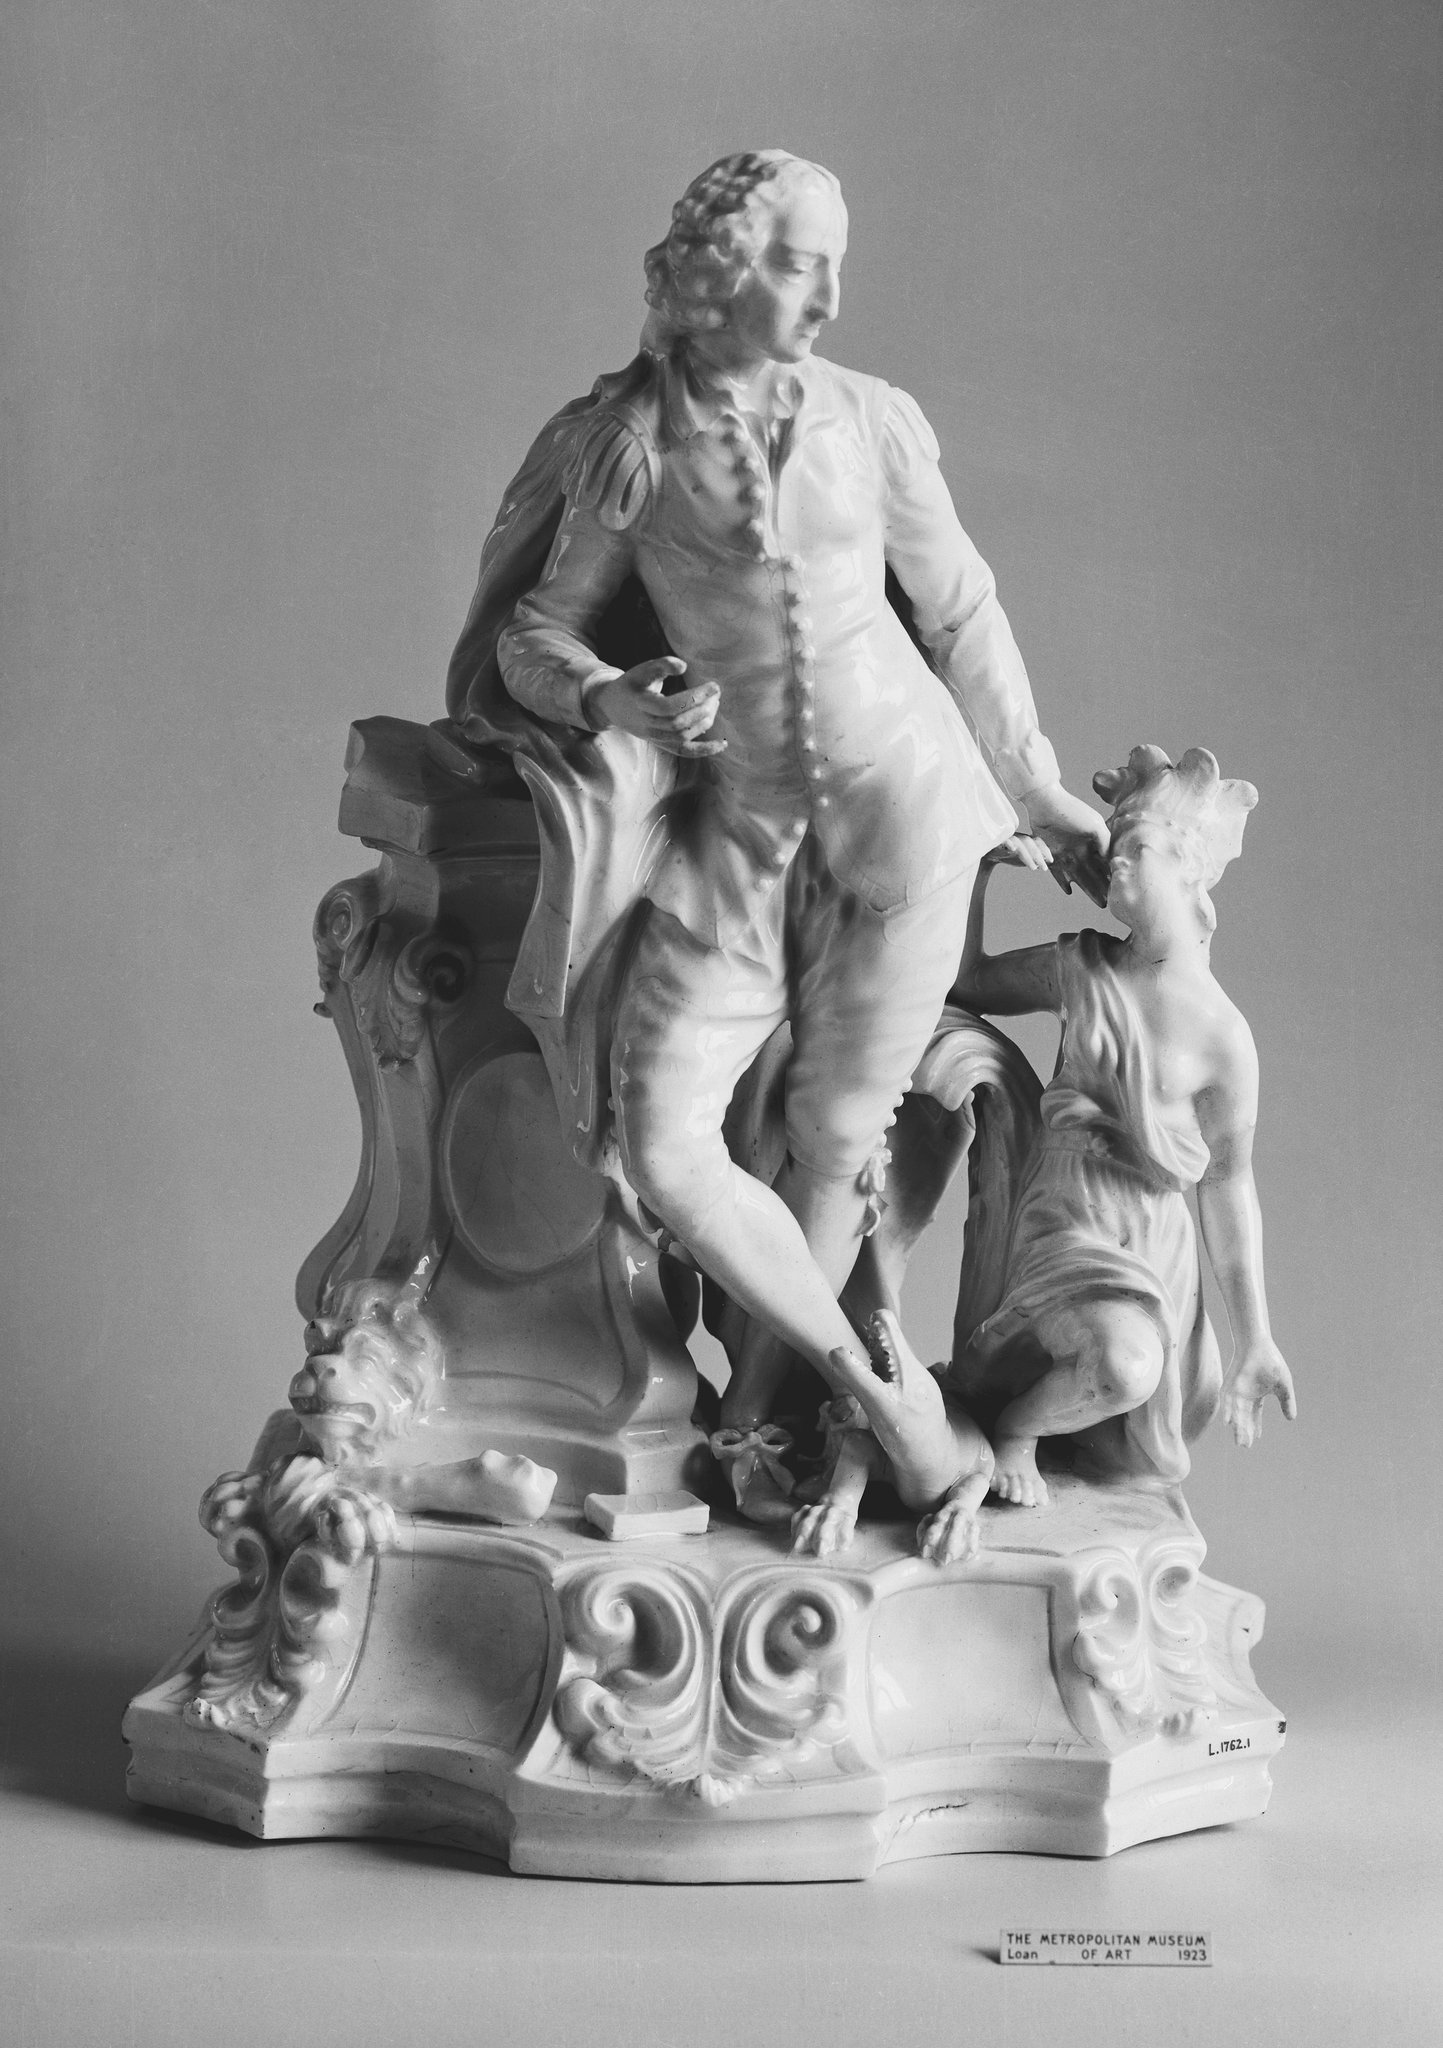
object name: figure group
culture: british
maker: chelsea factory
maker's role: maker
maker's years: 1742-1784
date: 1765-1775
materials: porcelain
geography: england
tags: men,women